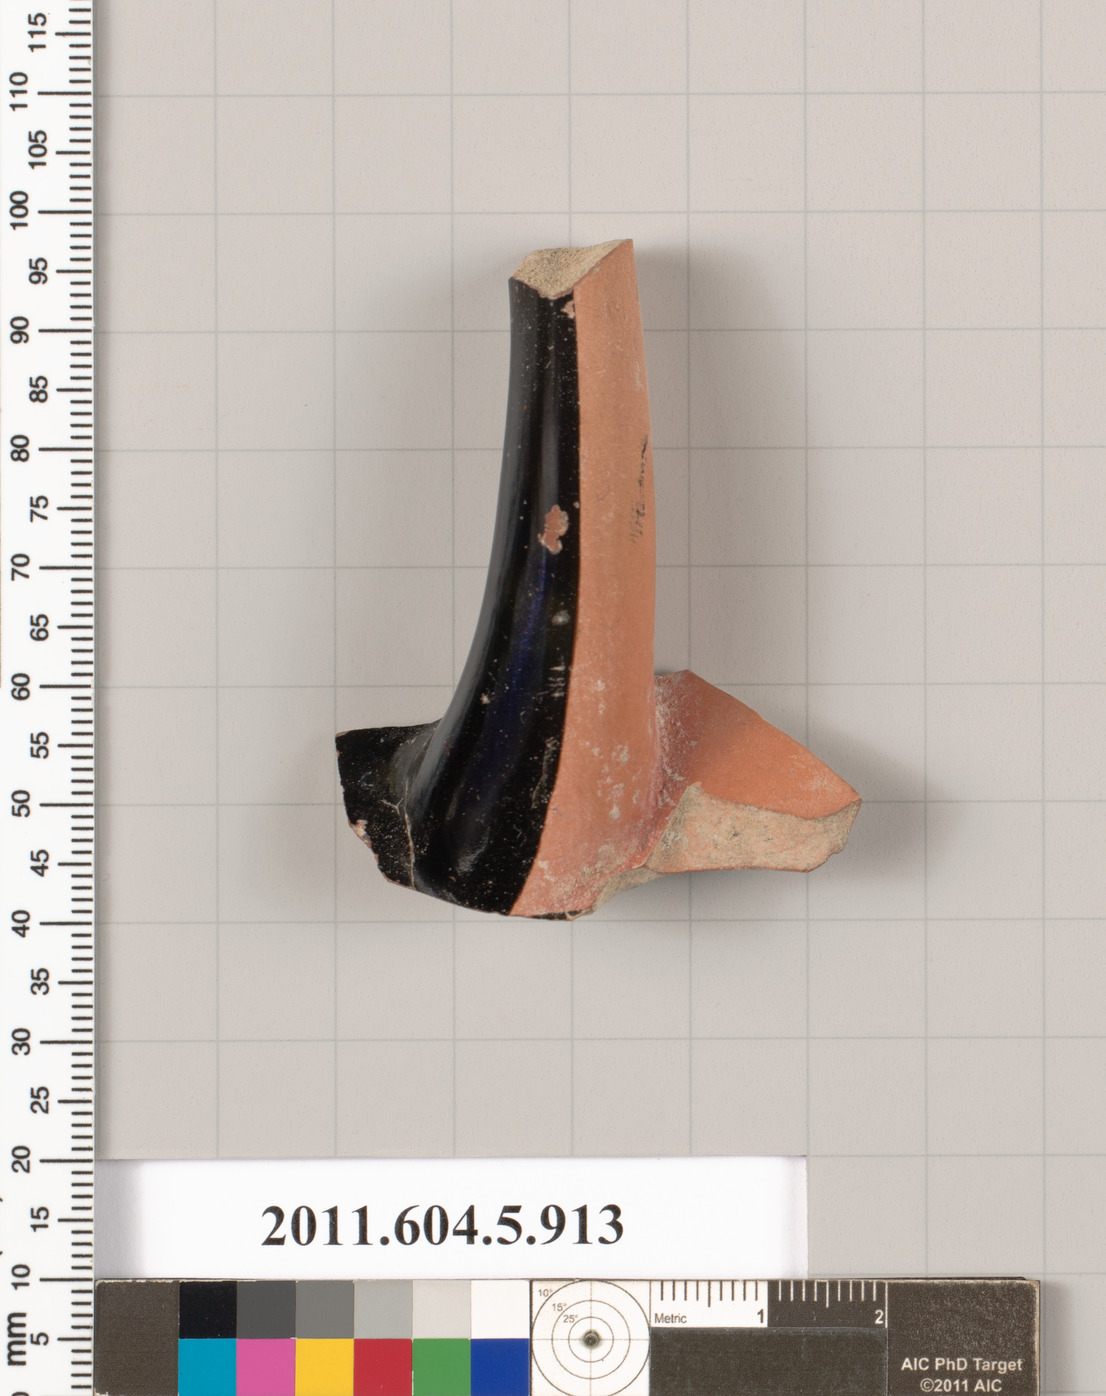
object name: kylix fragment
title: Terracotta fragment of a kylix (drinking cup)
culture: greek, attic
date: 600-401 BCE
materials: terracotta